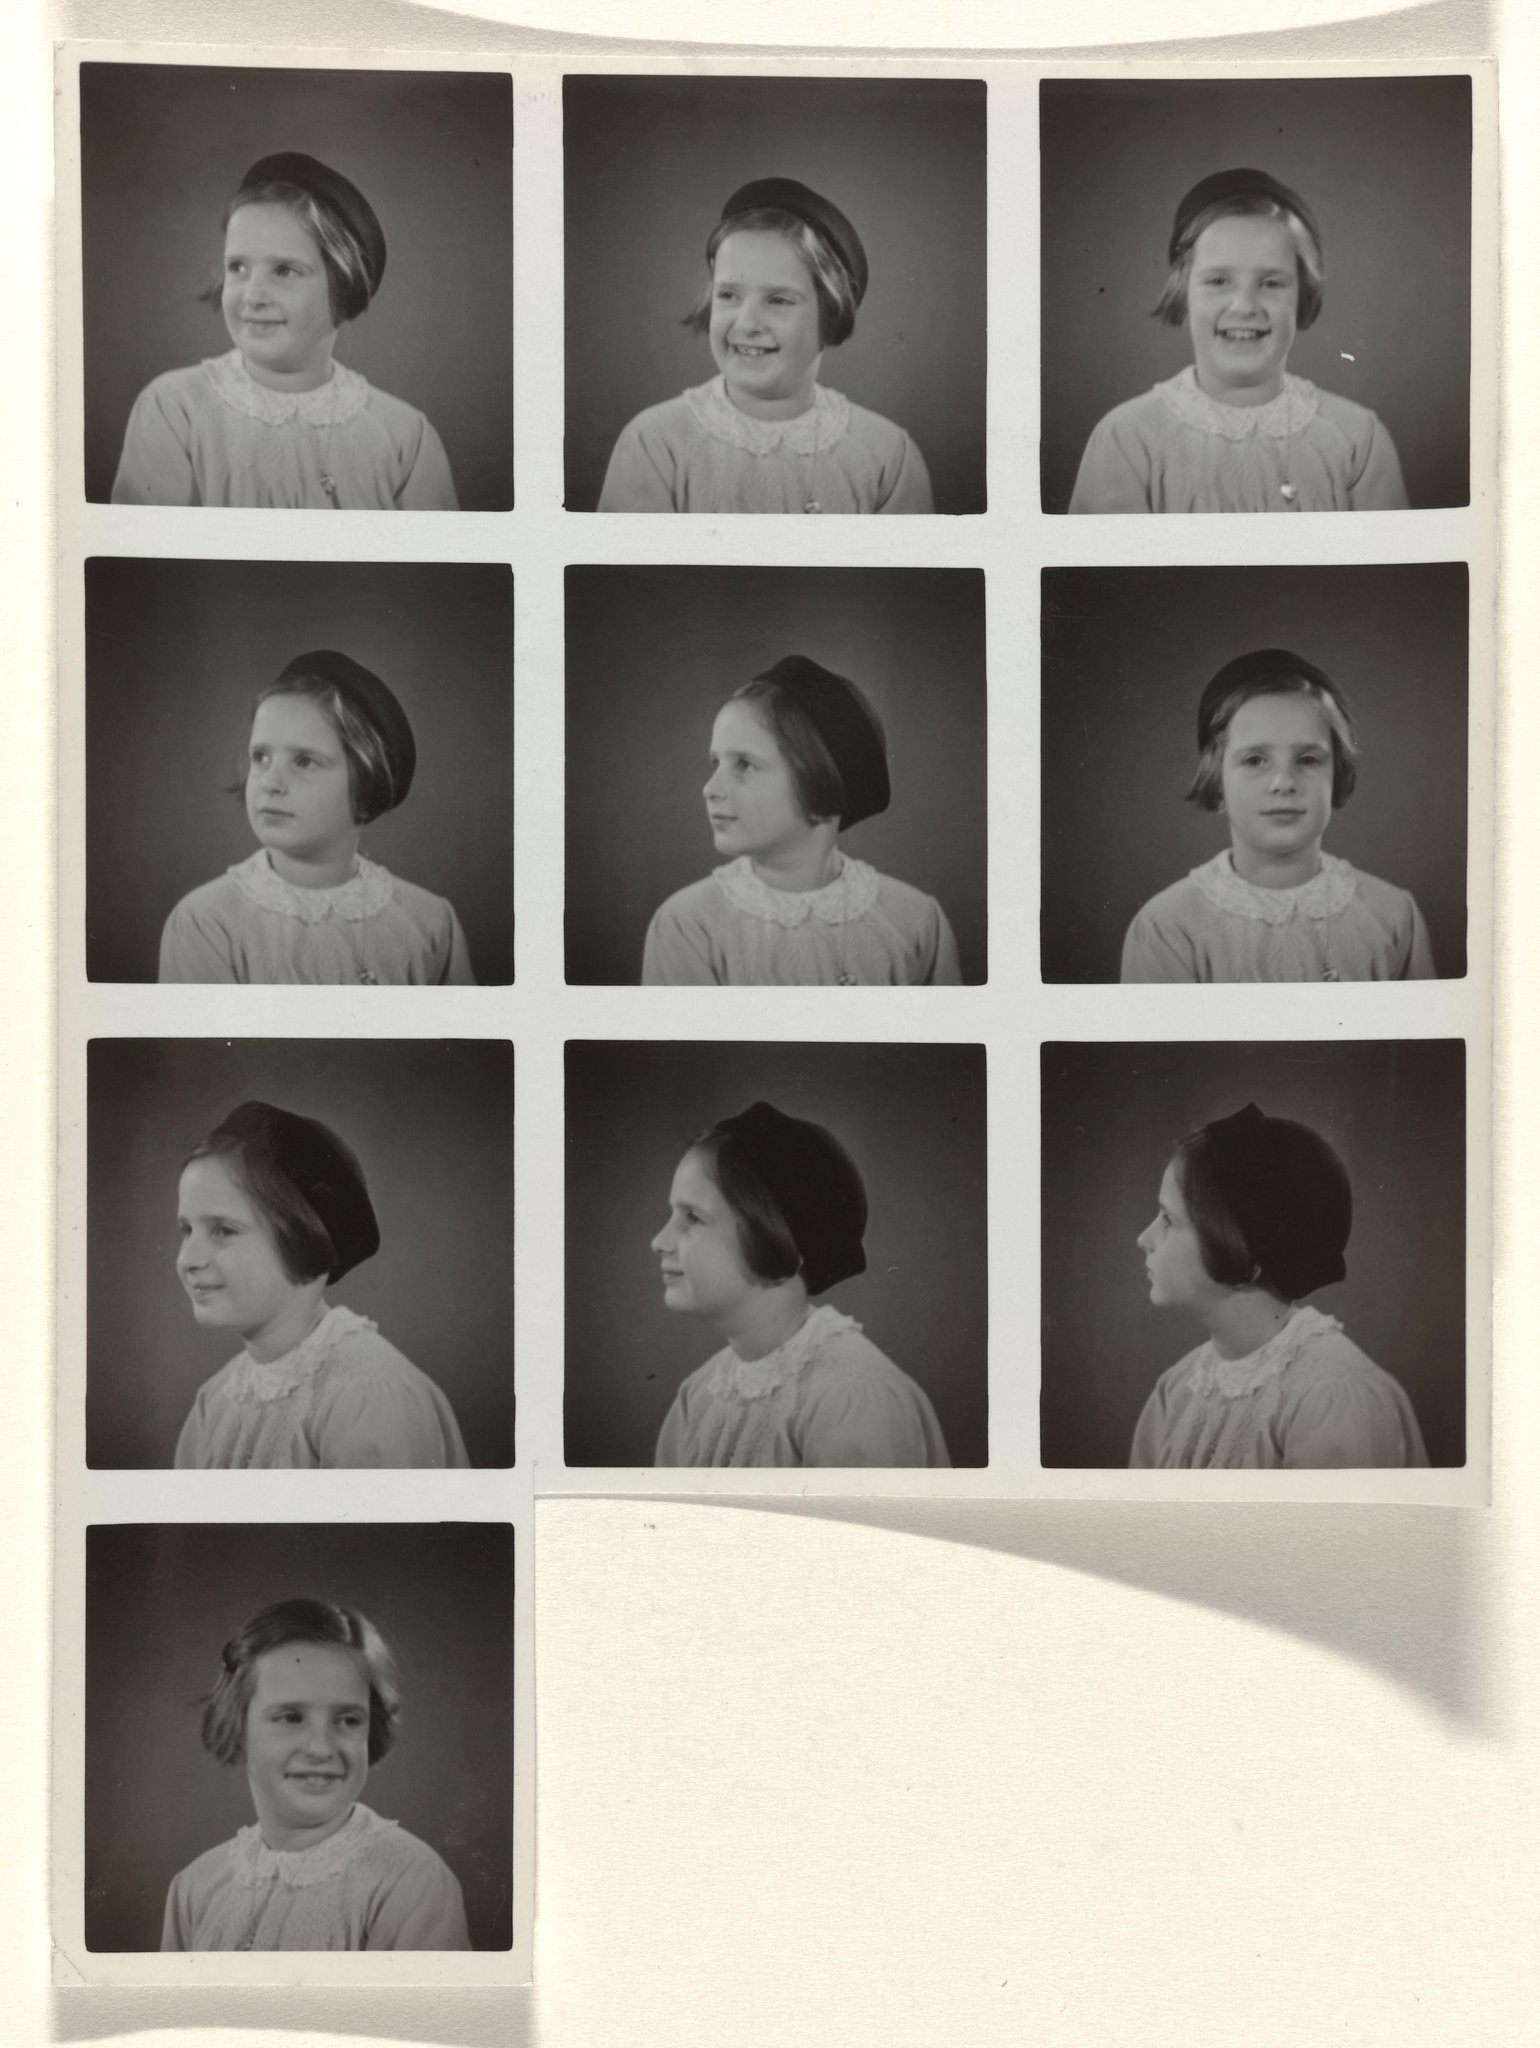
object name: photograph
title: Vel met pasfoto's van Isabel Wachenheimer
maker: Anonymous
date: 1931-1937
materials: photographic support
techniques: gelatin silver print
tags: isabel wachenheimer-elon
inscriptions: company name: ‘Polyfoto nummer Stuttgart-w. Marienstrasse 2.’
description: Dit object is onderdeel van de nalatenschap van Isabel Elon-Wachenheimer (1928-2010). Tot haar overlijden behoorde het samen met de andere objecten uit de nalatenschap tot haar privédomein van Isabel Wachenheimer. In die particuliere context zijn deze objecten tezamen en individueel aandenkens - aan de jeugd, ouders en familie van Isabel Wachenheimer vóór en tijdens de Shoah en aan haar leven na de Tweede Wereldoorlog. Isabel Wachenheimer, die van juni 1943 tot mei 1945 gevangen zat in Kamp Westerbork, Theresienstadt, Auschwitz, Lenzing a/d Oberdonau (een buitenkamp van Mauthausen), overleefde de Shoah. Haar ouders – Eugène Wachenheimer en Else Wachenheimer-Moos - werden op 14 oktober 1944 in Auschwitz-Birkenau vermoord.